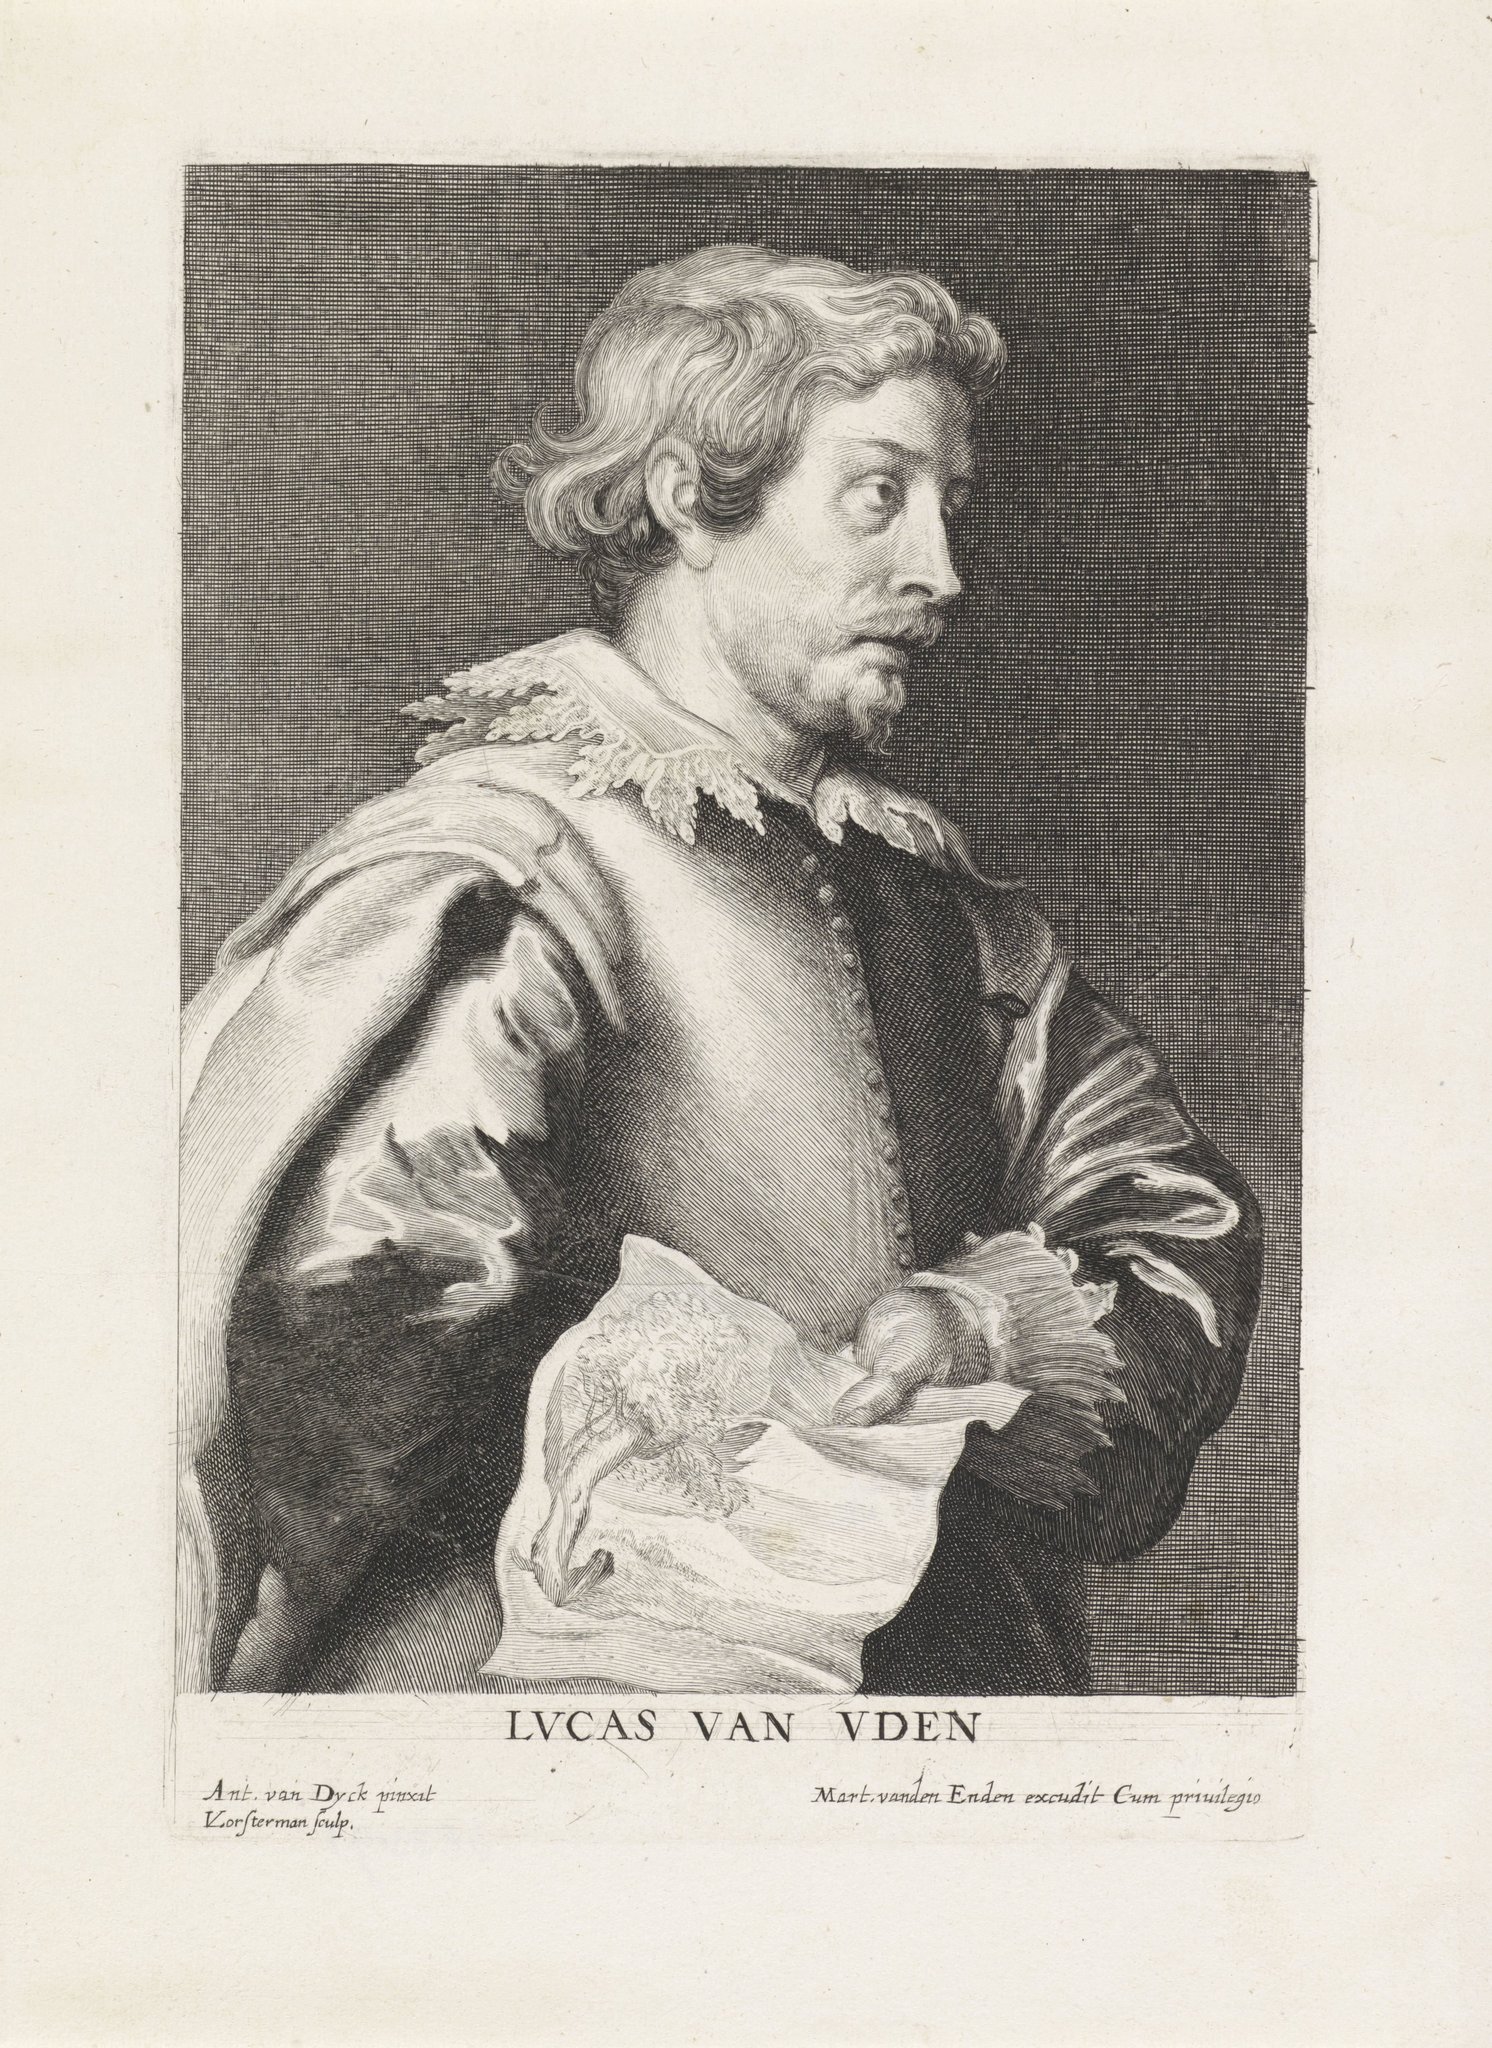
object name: print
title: Portret van Lucas van Uden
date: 1630-1646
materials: paper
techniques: engraving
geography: antwerp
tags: antwerp, print maker, draughtsman, lucas van uden, drawing, sketch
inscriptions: collector's mark: Lugt 240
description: Prent gebruikt voor: Icones principum, virorum doctorum, pictorum, chalcographorum, statuariorum nec non amatorum pictoriae artis numero centum ab Ant. van Dyck ad vivum expressae ejusque sumptibus aeri incisae. Antwerpen: Gillis Hendricx, [1645-1646].